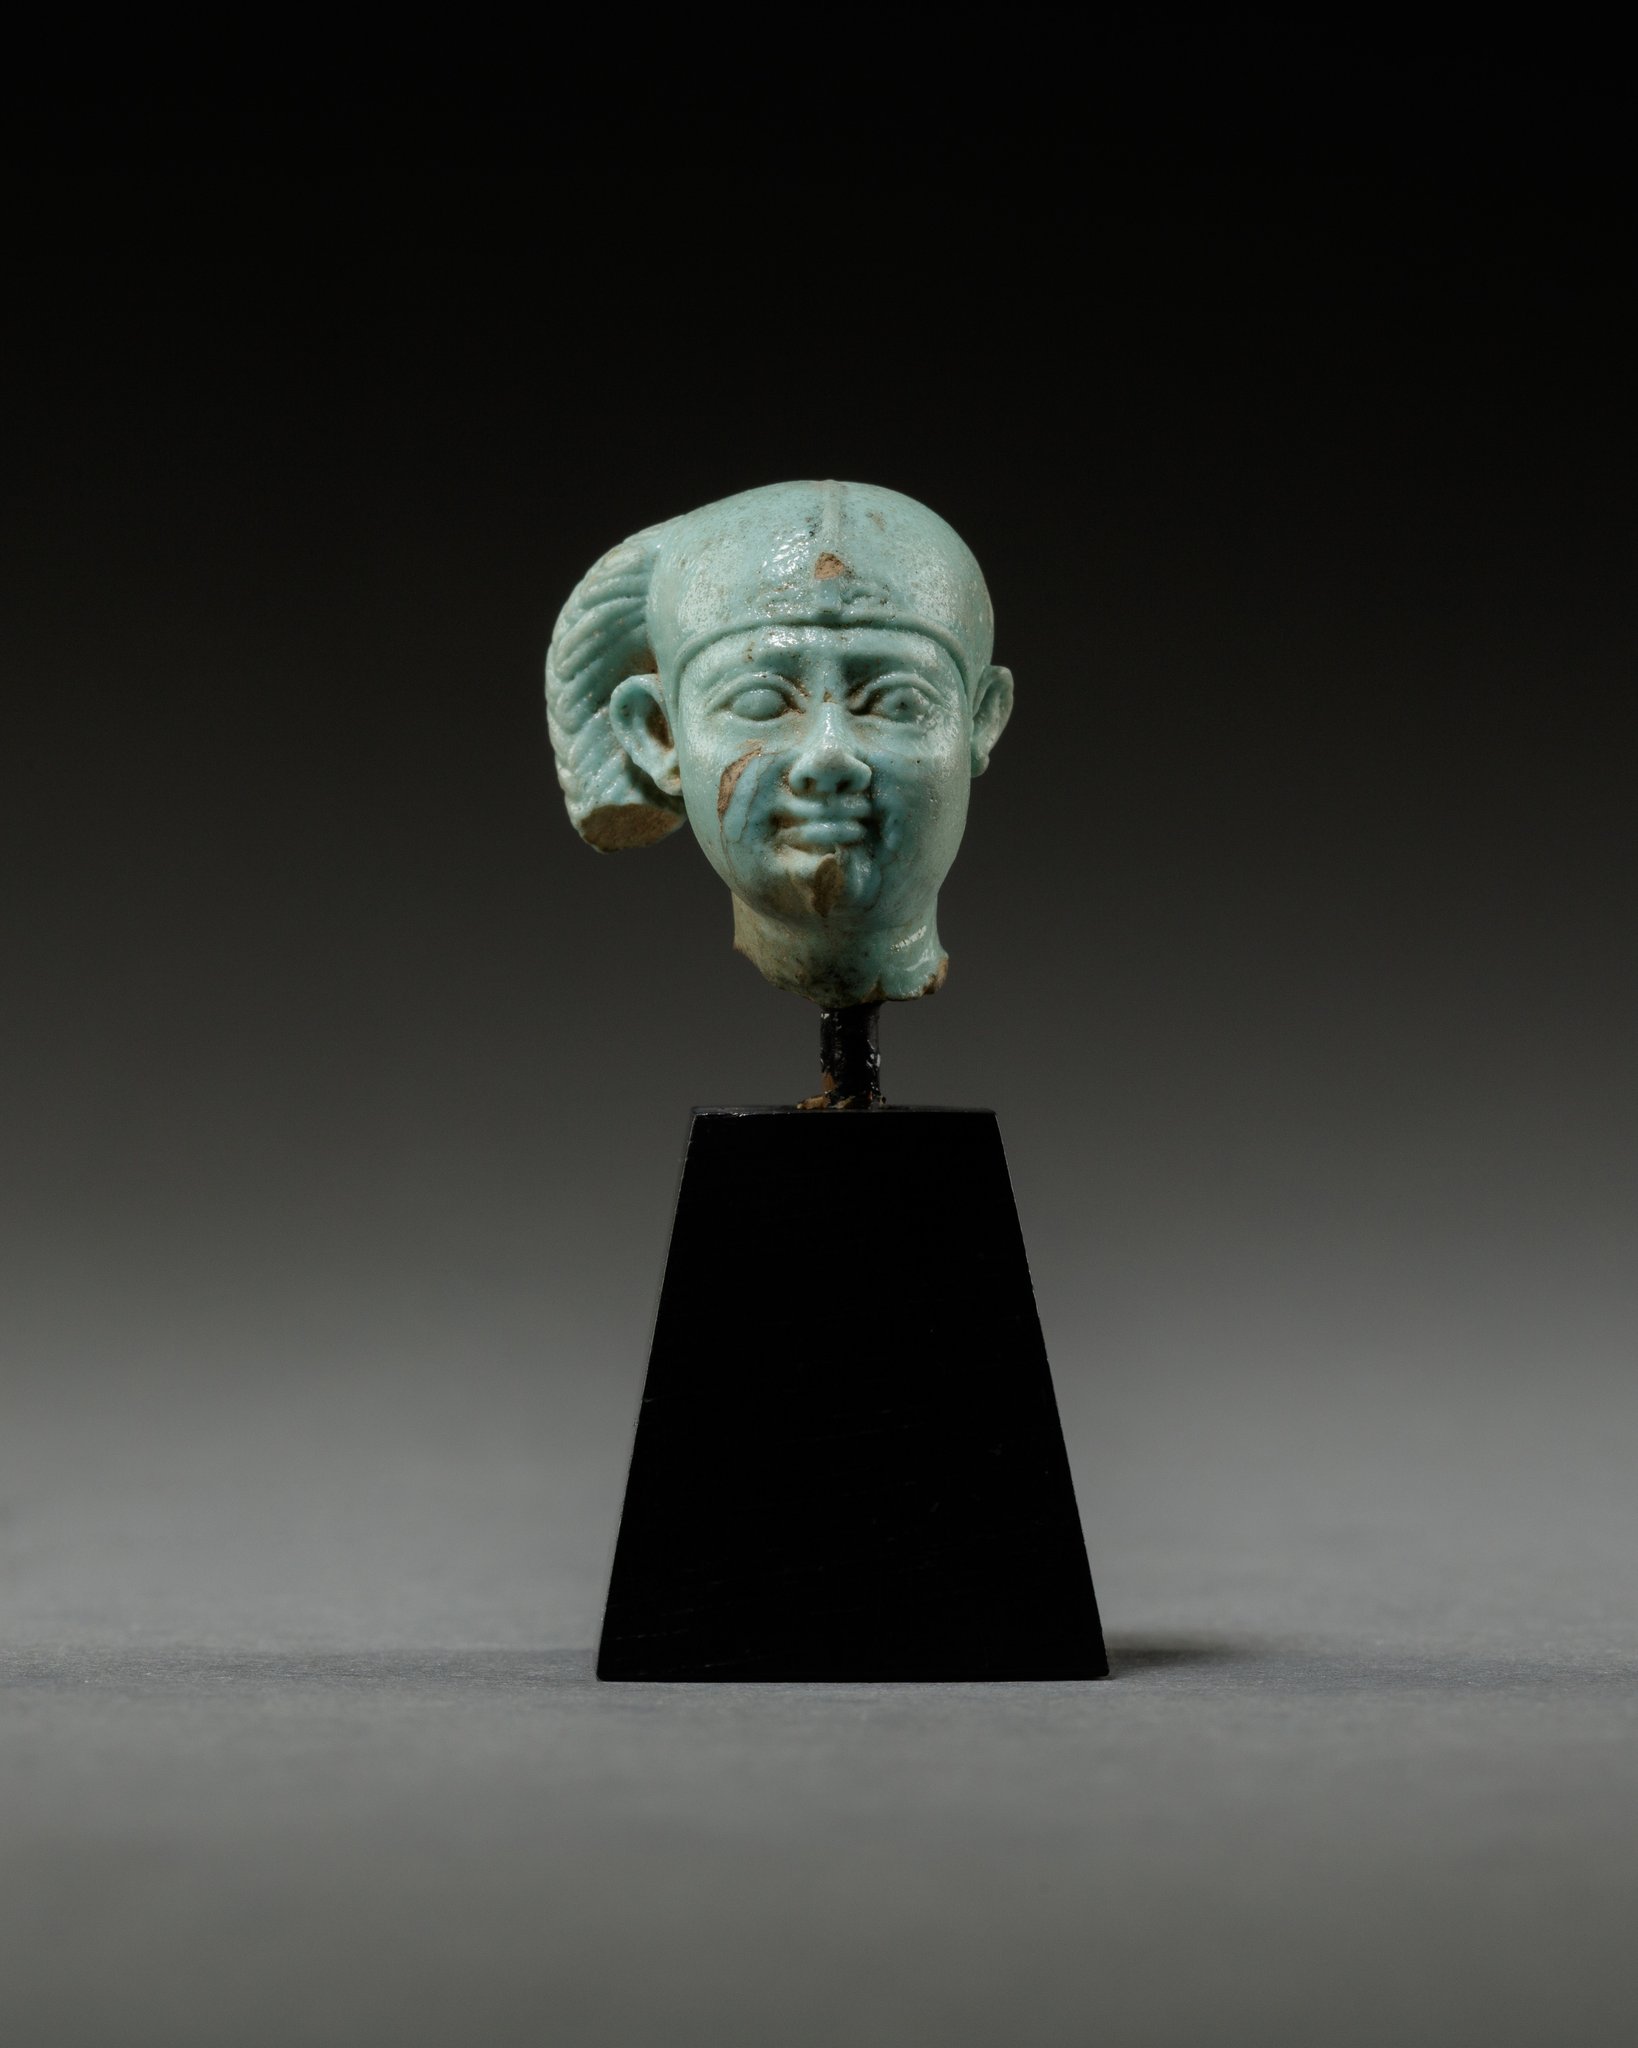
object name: head from an amulet of harpokrates, child god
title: Head from a figure of a child god, perhaps Harpokrates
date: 664-630 BCE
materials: faience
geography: egypt